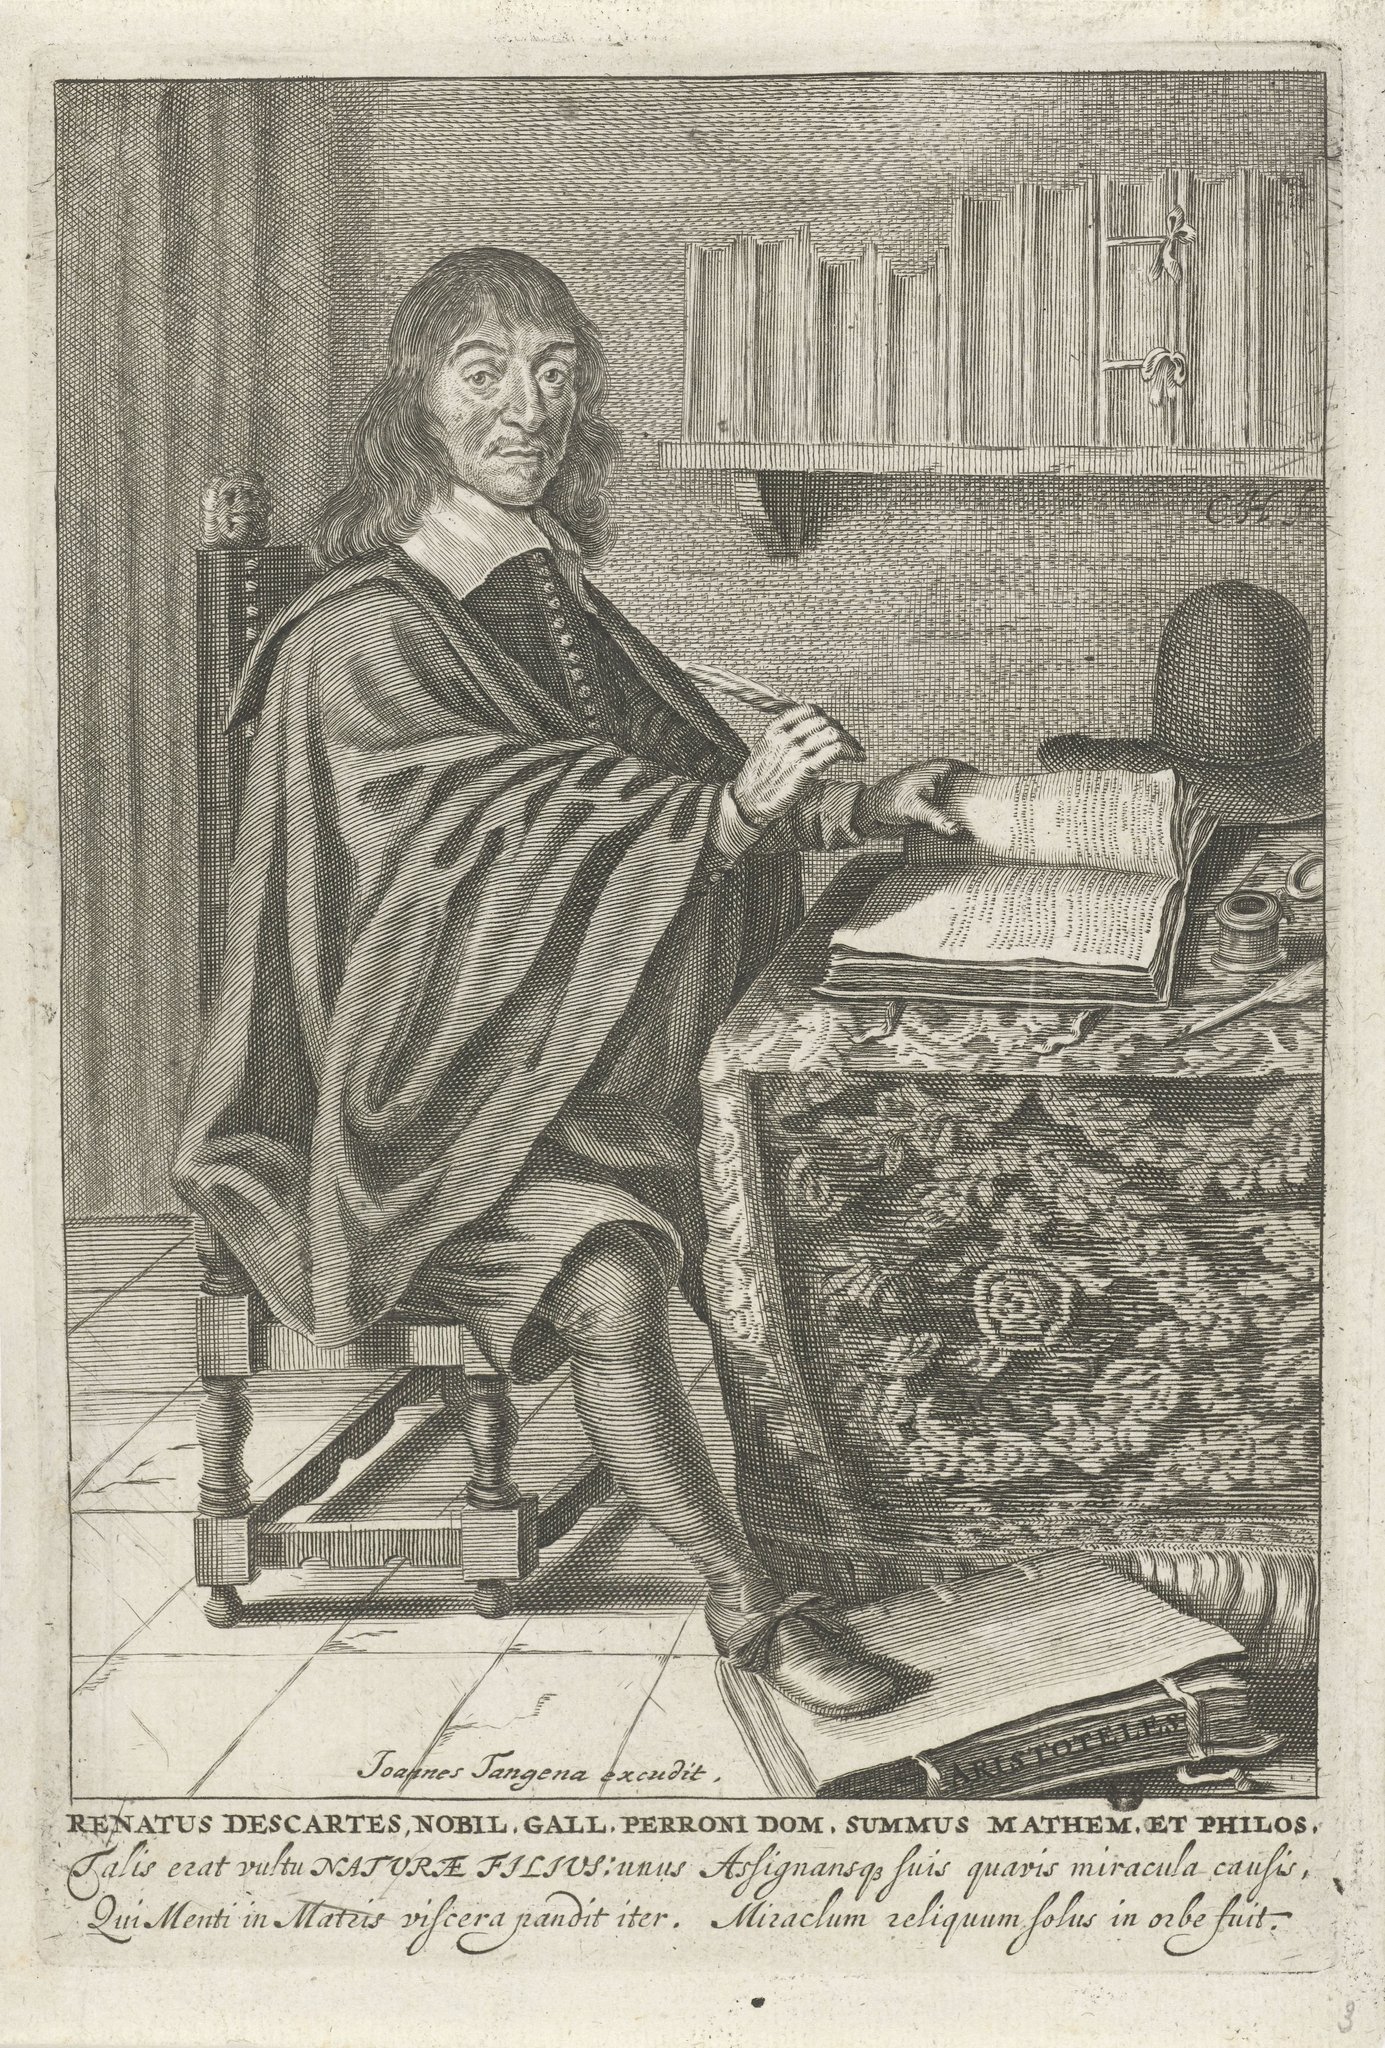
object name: print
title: Portret van René Descartes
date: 1687-1691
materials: paper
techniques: engraving, etching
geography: leiden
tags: rené descartes, scholar in his study, ink-well, book - mm - book open, table, book, writing accessories, chair, theologian in his study (writing or reading), table-cloth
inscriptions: collector's mark: Lugt 2228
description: Portret van René Descartes, zittend aan een tafel. Voor hem een open boek, een hoed en een inktpot, in zijn rechterhand een ganzenveer. Zijn linkervoet rust op een boek op de grond, waar op de zijkant staat: Aristoteles. Onder het portret zijn naam en een tweeregelige tekst in het Latijn.